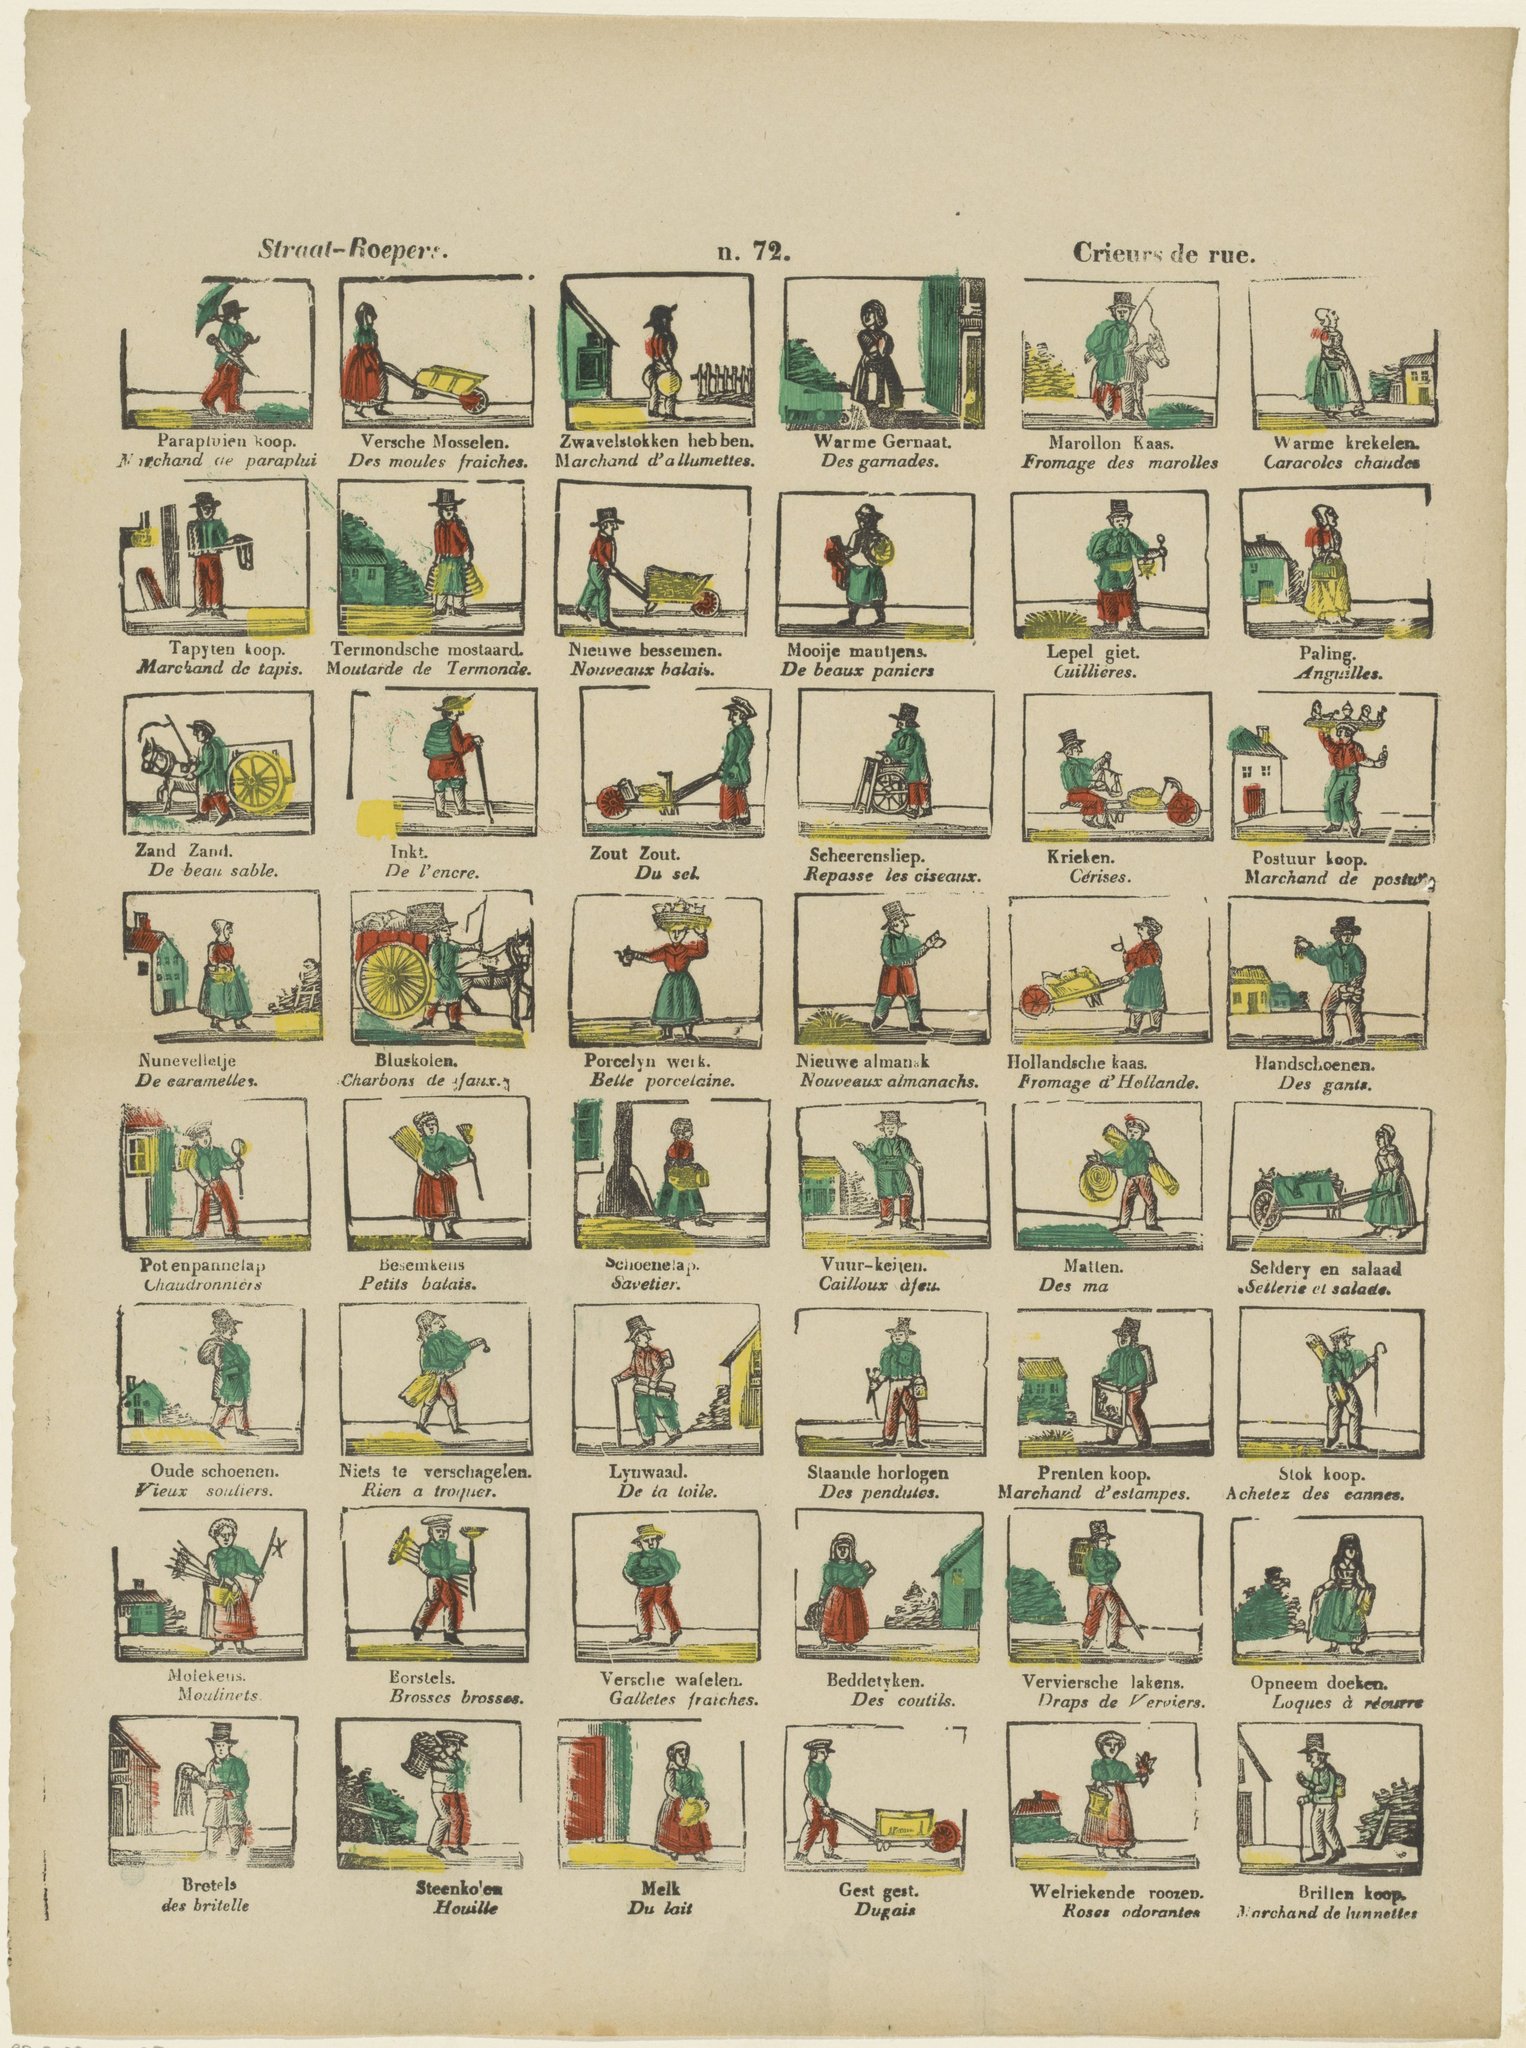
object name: print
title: Straat-roeper / Crieurs de rue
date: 1866-1902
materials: paper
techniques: colour, letterpress printing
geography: turnhout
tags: street-trader, merchant, salesman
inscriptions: collector's mark: Lugt 2760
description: Blad met 48 voorstellingen van straatverkopers, zoals een bezemverkoper, een kaasverkoper en een rozenverkoopster. Onder elke afbeelding een onderschrift in het Nederlands en in het Frans. Genummerd midden boven: n. 72.